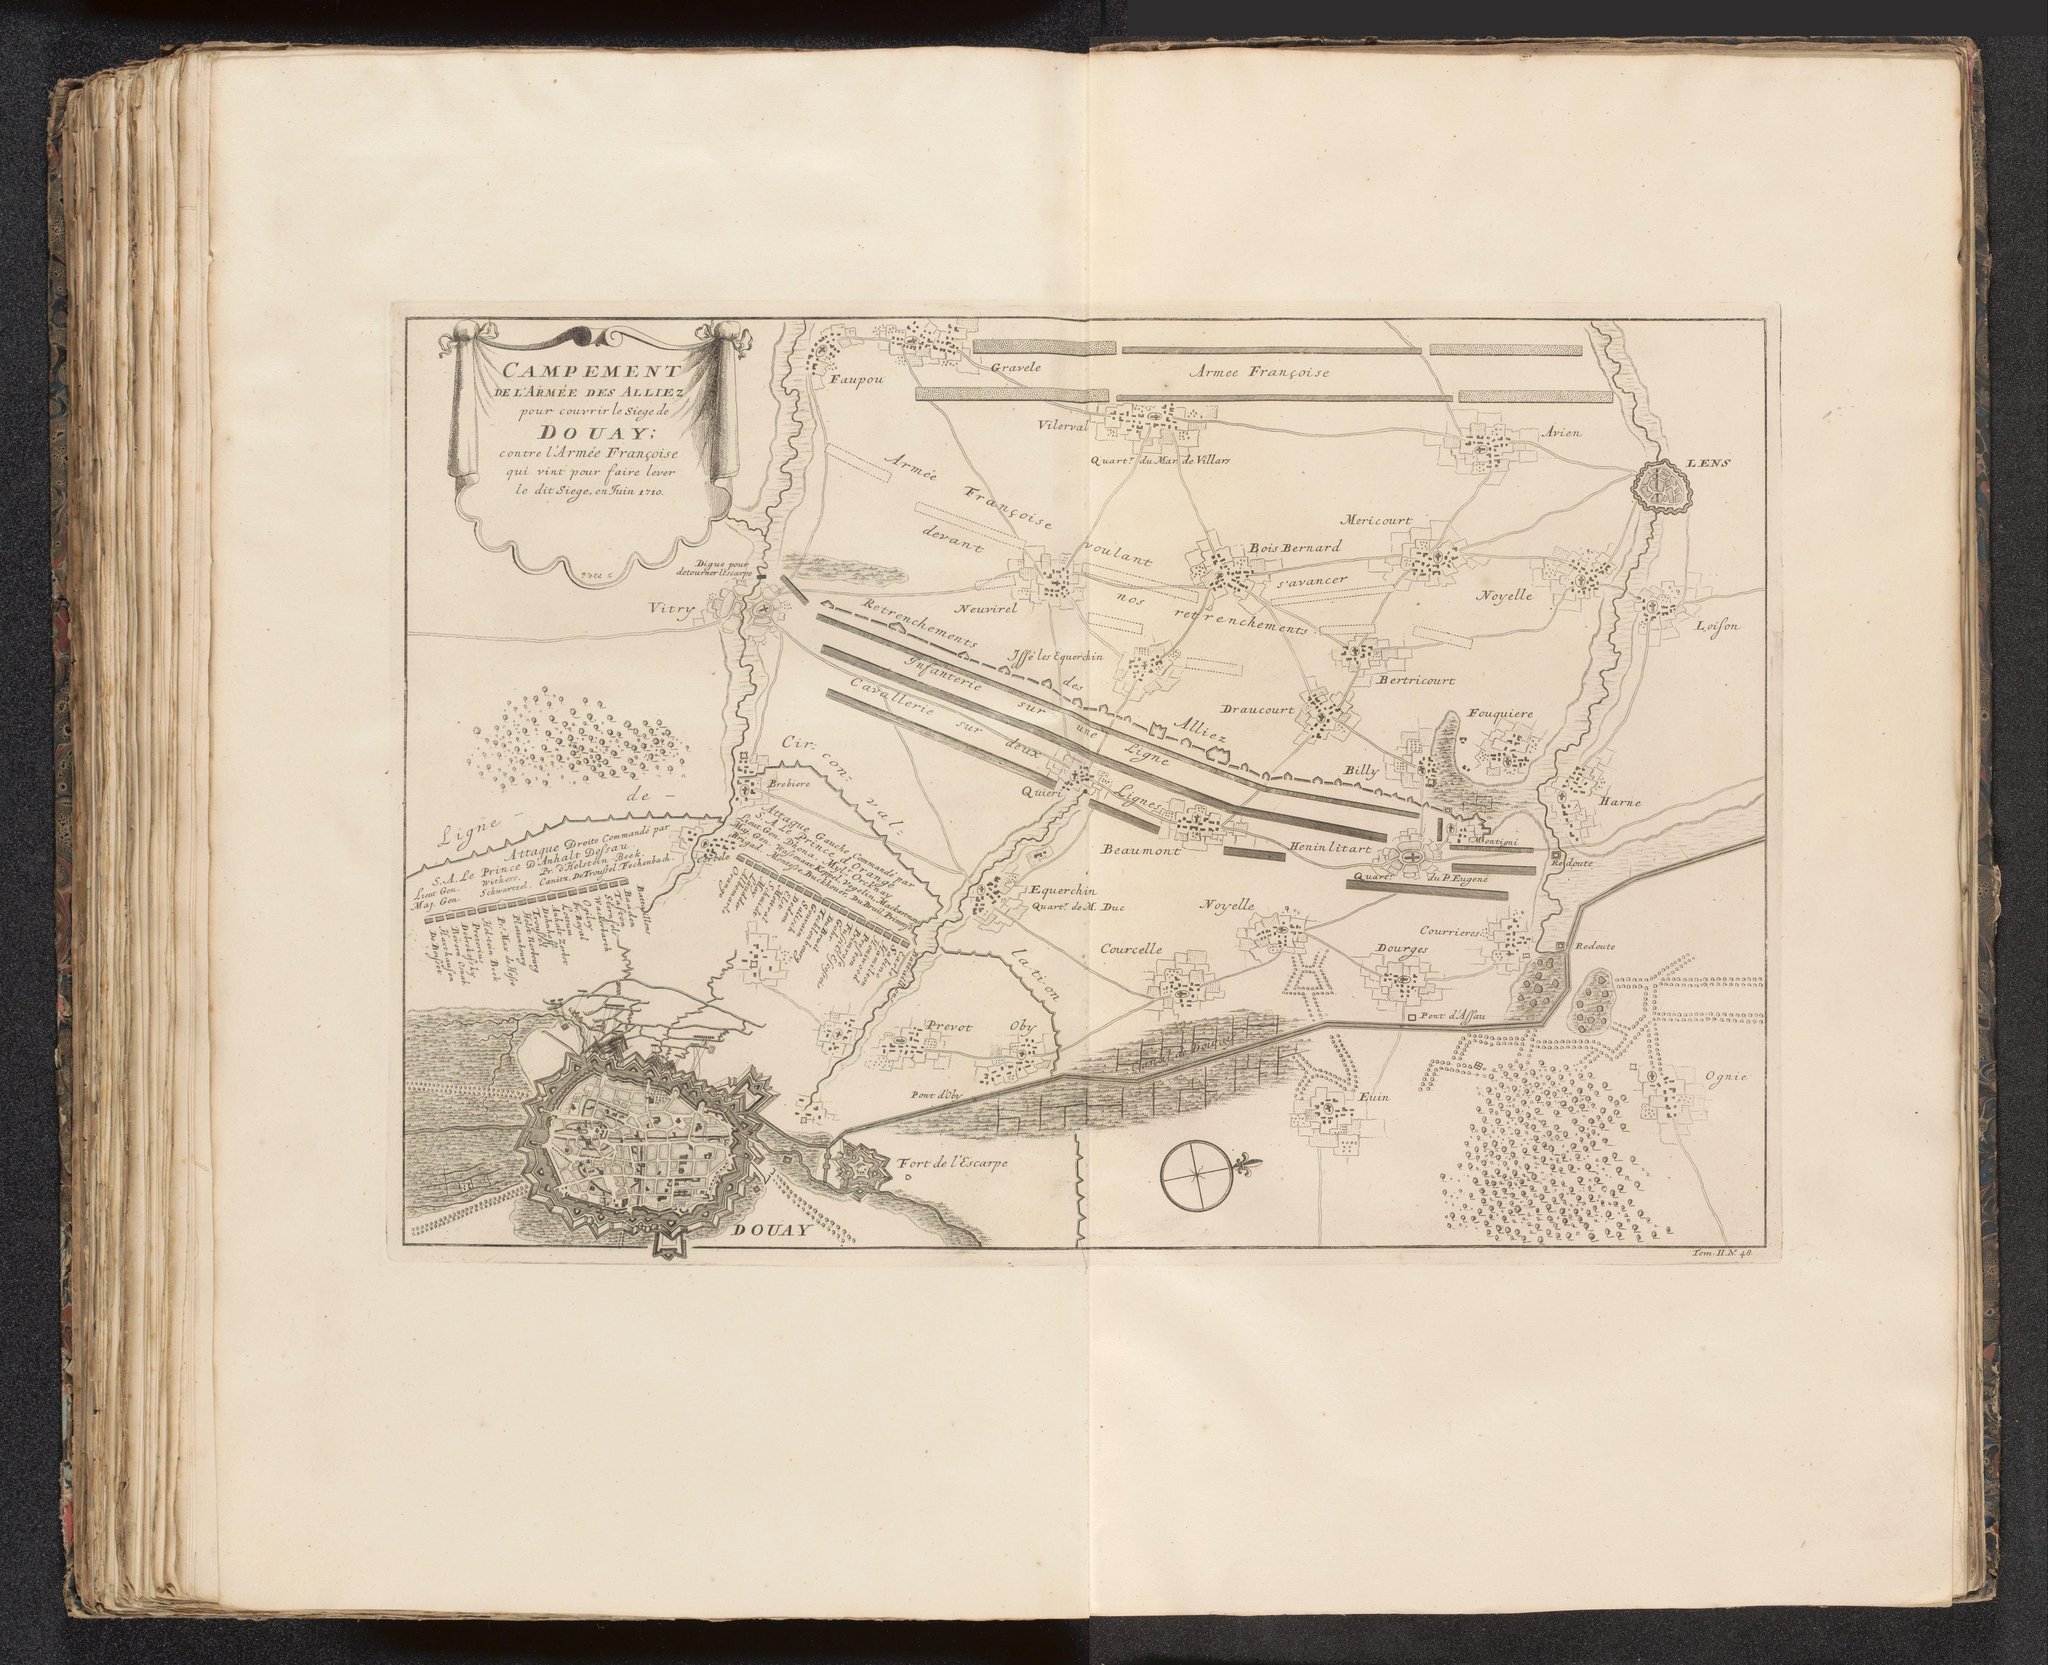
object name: map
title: Campement de l'Armée des Alliez pour couvrir le Siege de Douay; contre l'Armée Françoise qui vint pour faire lever le dit Siege, en Juin 1710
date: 1710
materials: paper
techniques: etching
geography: the hague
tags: johan willem friso (prins van oranje-nassau), john churchill (1e hertog van marlborough), (military) camp with tents, siege, position war, maps of cities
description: Kaart van het legerkamp van de Geallieerden bij het beleg van Douai door de Geallieerden onder de prins van Oranje, ingenomen op 29 juni 1710. Rechtsboven de posities van het Franse leger dat ter ontzet is gekomen. Genummerd rechtsonder: Tom. II. No. 48. Illustratie in het tweede deel van : [Jean] du Mont, Oorlogskundige beschryving van de veldslagen en belegeringen, der drie ... wydvermaarde krygsoversten... den Prins Eugenius van Savoye, den ... Hertog van Marlborough, en den Prins van Oranje en Nassau-Vriesland, in de editie van 1729. Dit tweede deel is hoofdzakelijk gewijd aan de daden van de hertog van Marlborough en prins Johan Willem Friso.